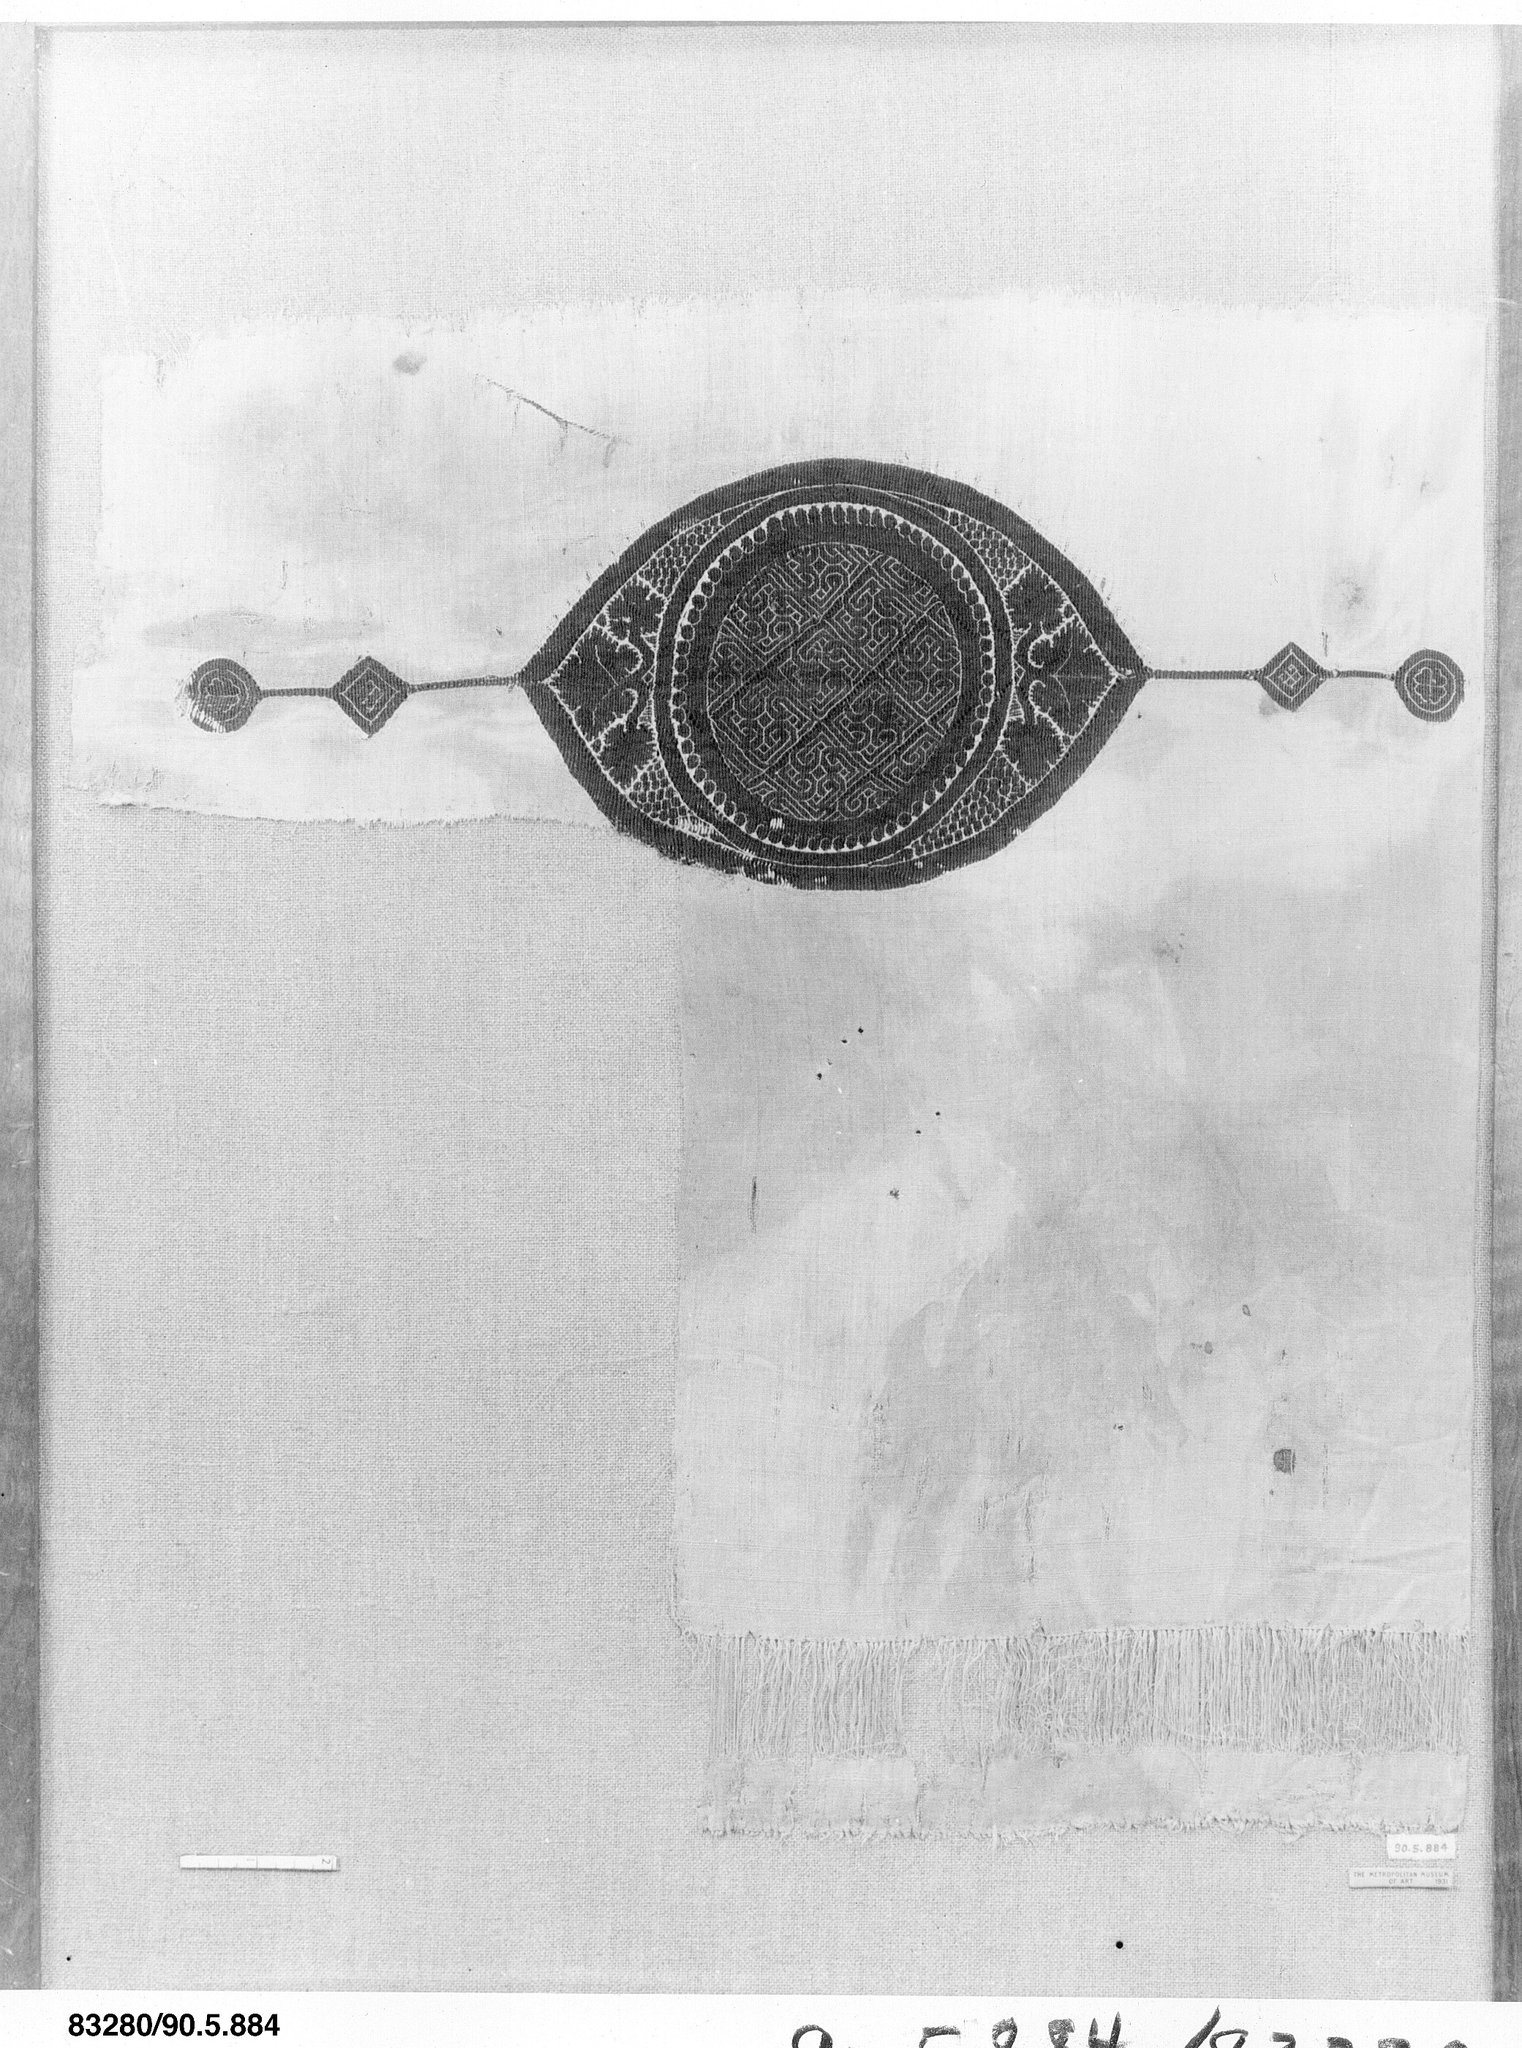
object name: textile fragment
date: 201-400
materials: linen, wool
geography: egypt